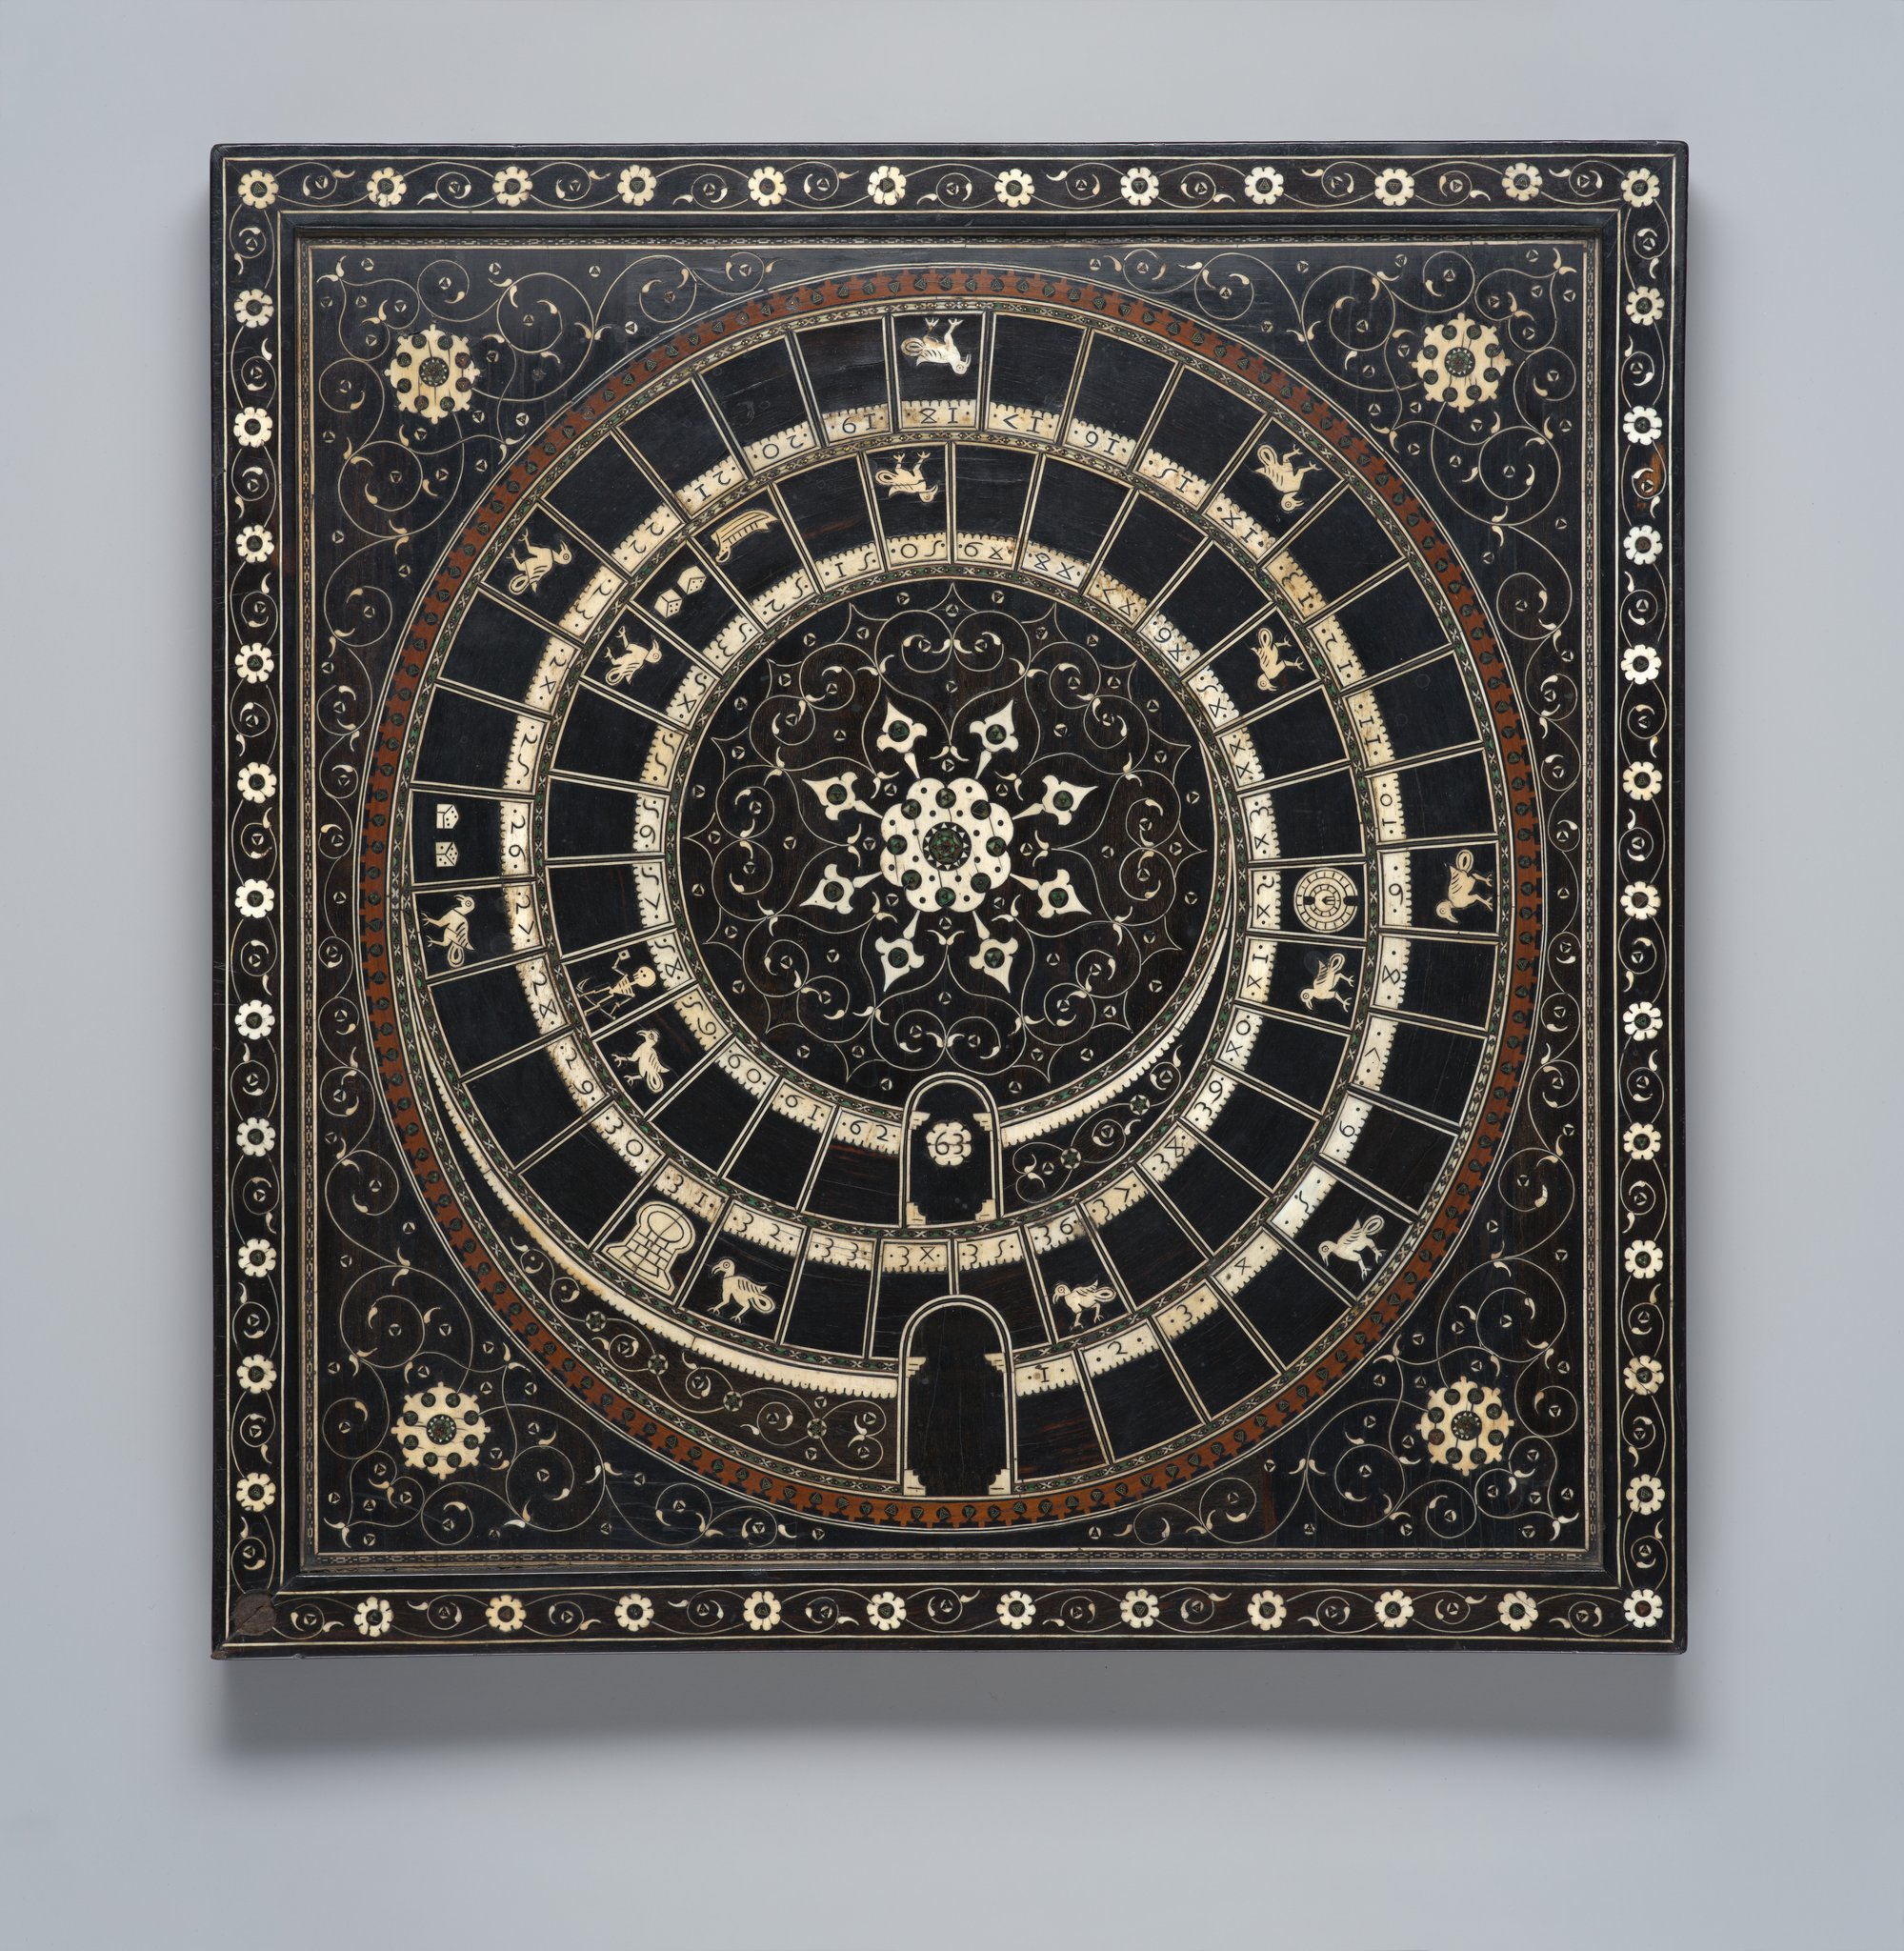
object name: gameboard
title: Chess and goose game board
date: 1567-1600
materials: wood, gold, horn, ivory, metal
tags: chess,games